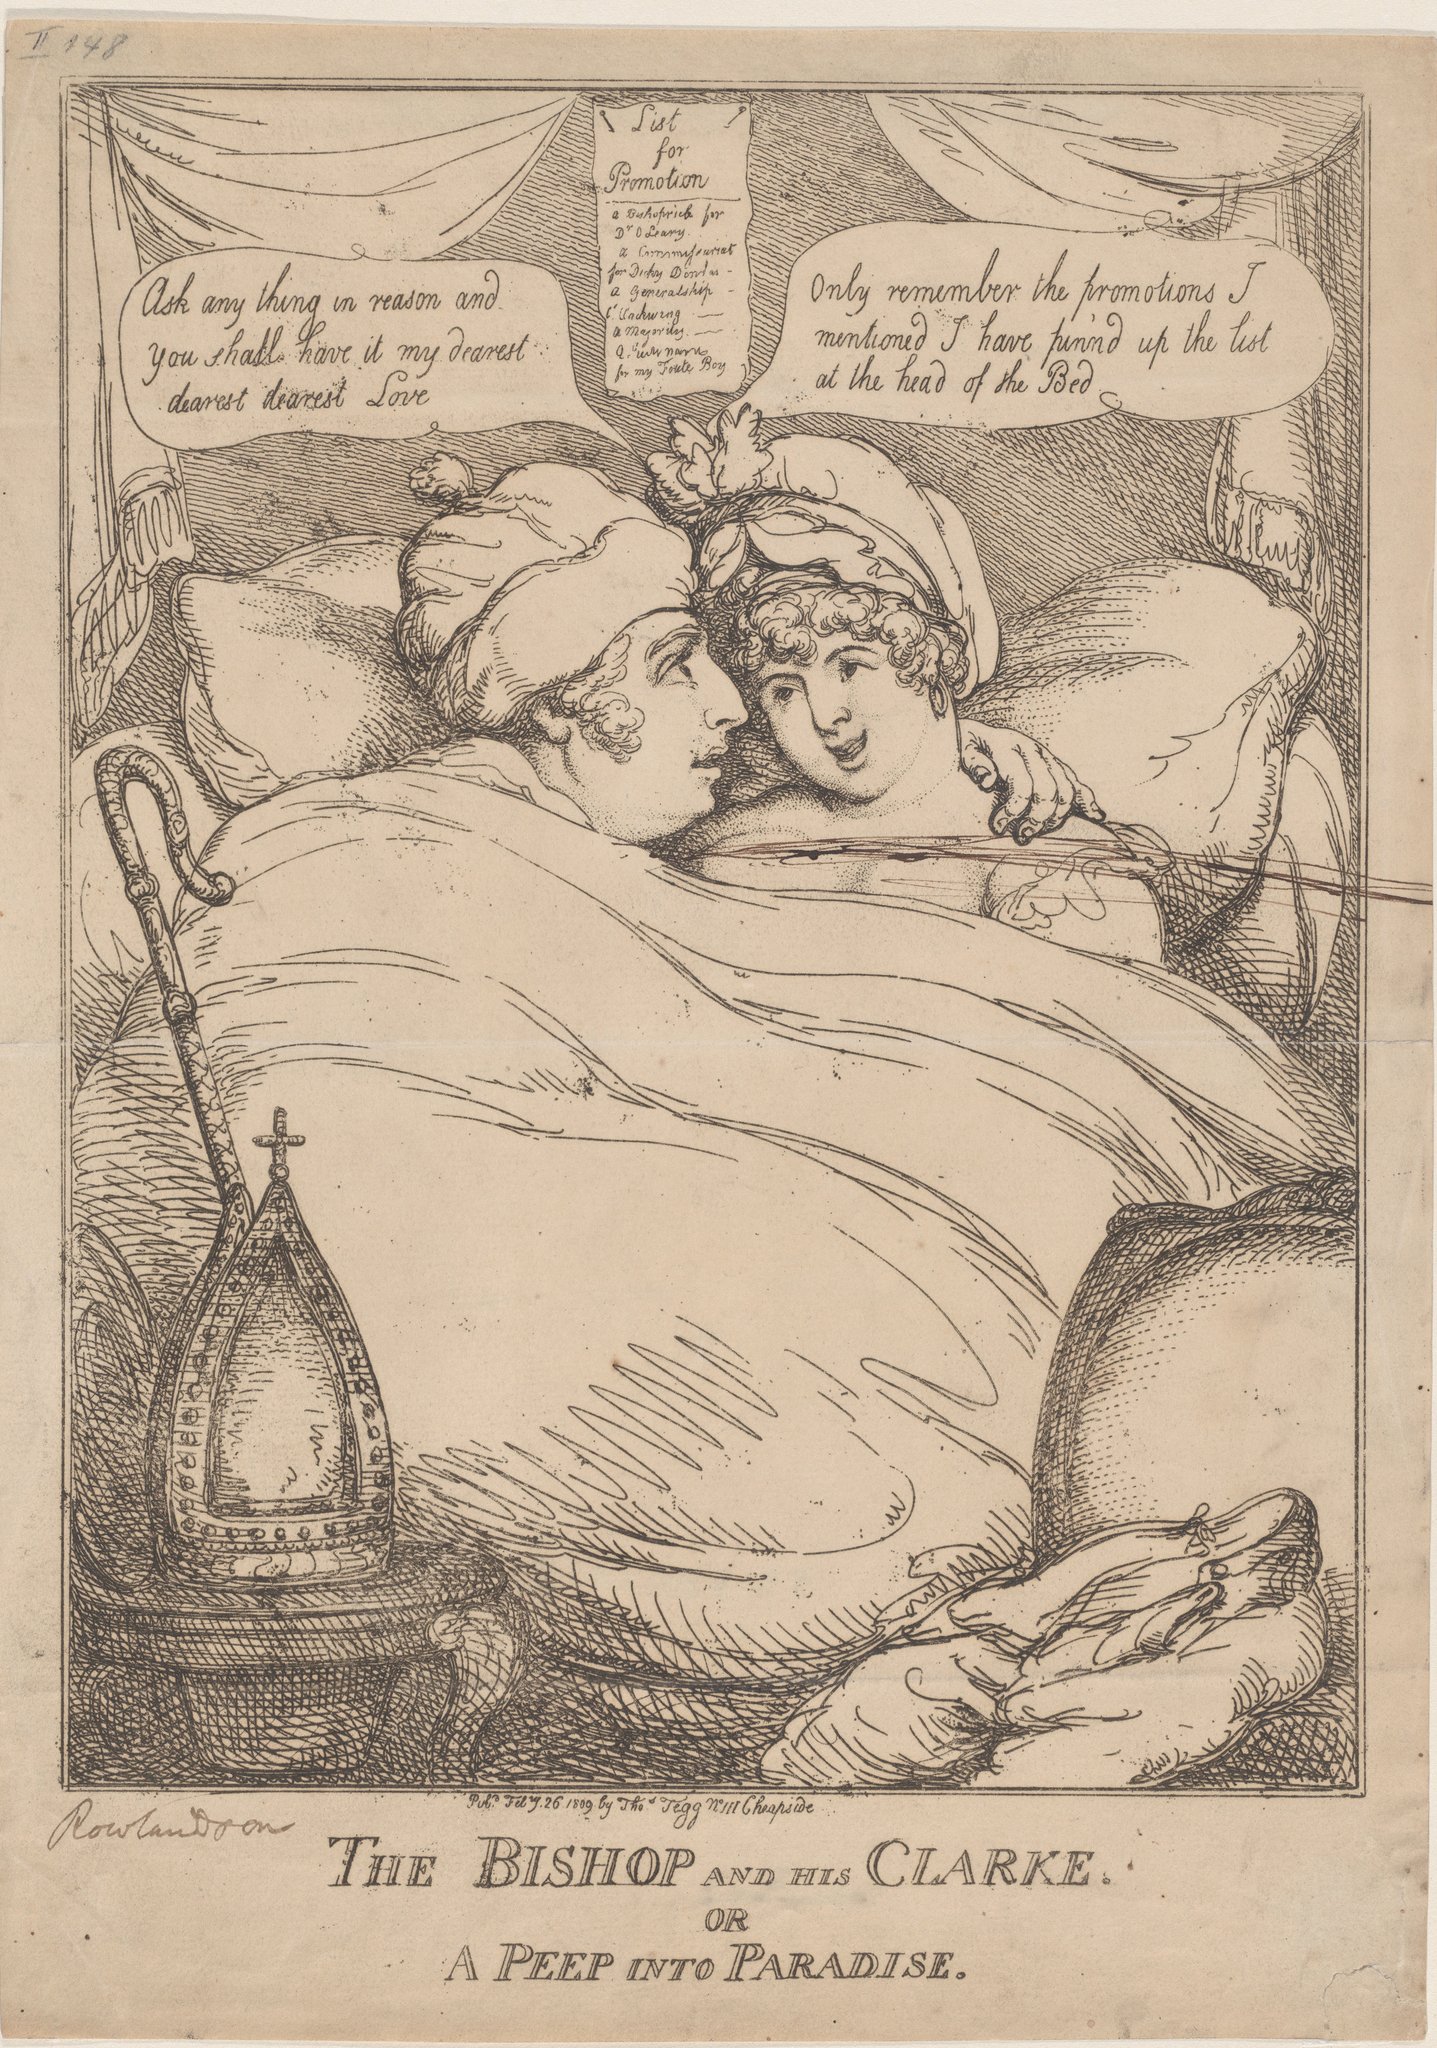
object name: print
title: The Bishop and His Clarke, or, A Peep into Paradise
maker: thomas rowlandson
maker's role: artist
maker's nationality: british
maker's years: 1757-1827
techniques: etching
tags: satire,couples,men,women,politics